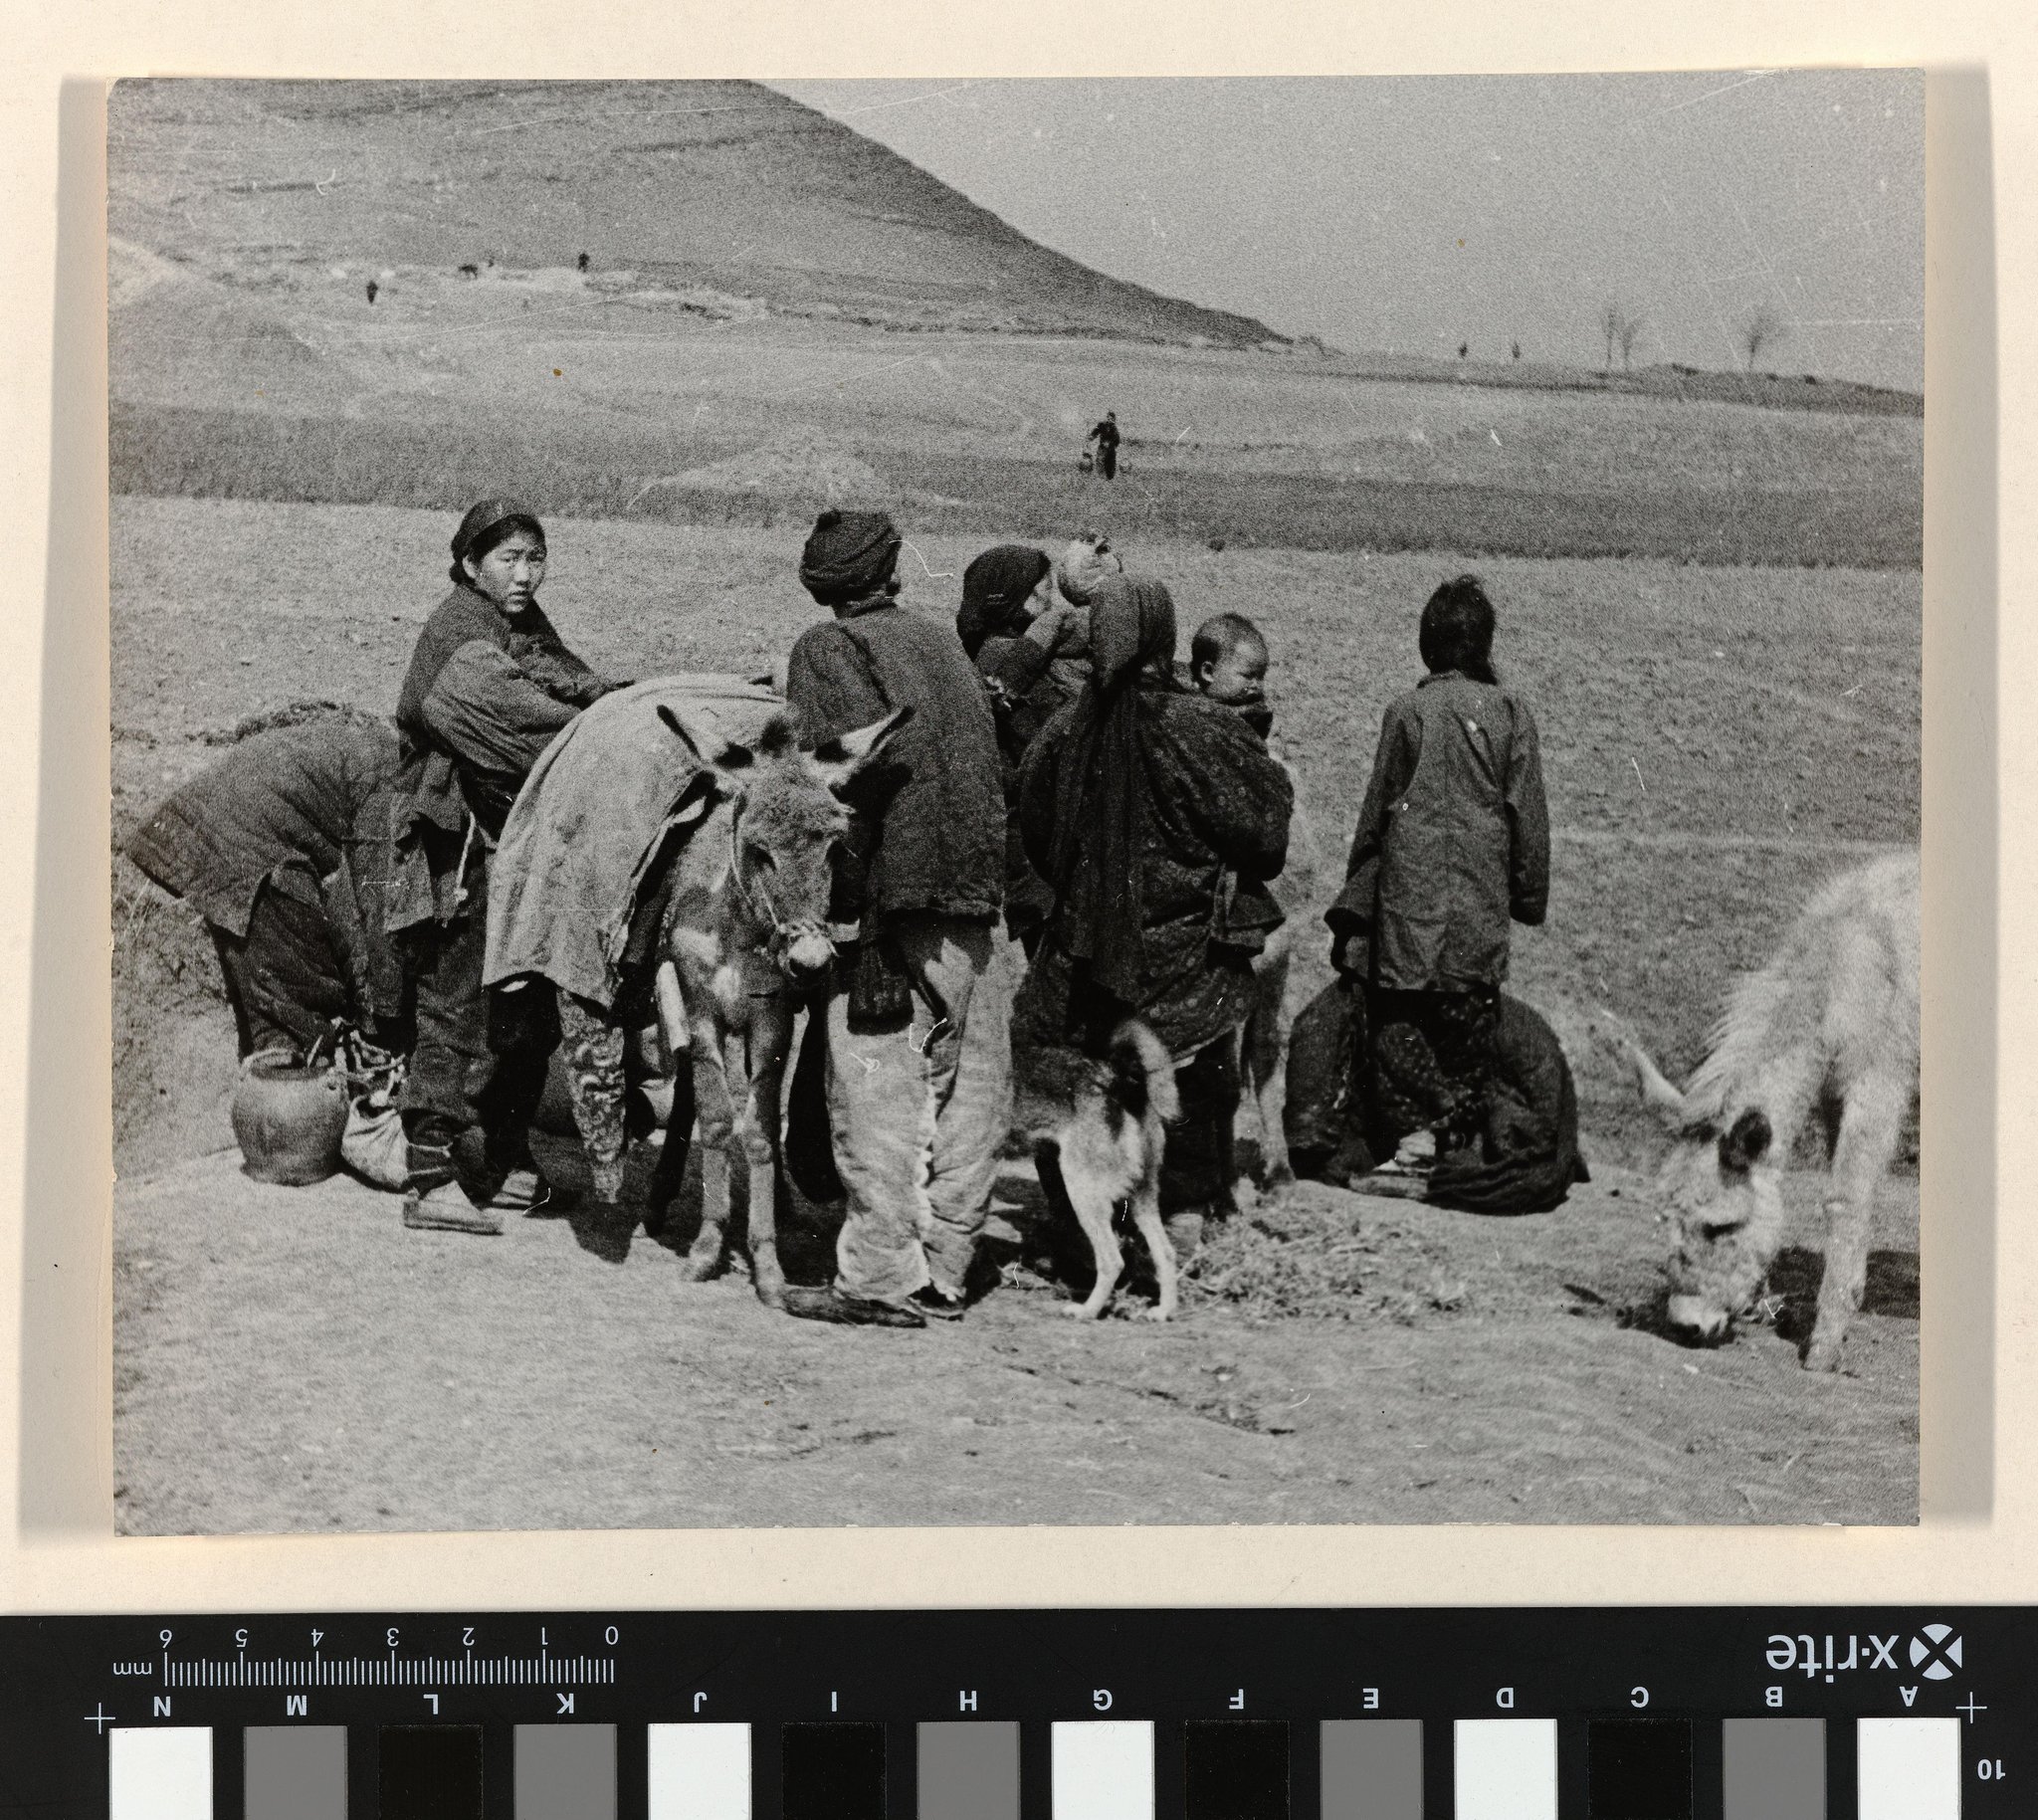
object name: news photograph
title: Groep mensen met dieren in het veld, China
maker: robert capa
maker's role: fotograaf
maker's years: 1913-1954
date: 1938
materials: paper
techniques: gelatin silver print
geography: new york city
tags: fugitives 'en route', ass, donkey, china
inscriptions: stamp: ‘PHOTO BY:/ PIX PUBLISHING INC./ 250 PARK AVENUE/ NEW YORK CITY/ TEL.ELDORADO 5-4021/ PLEASE CREDIT ROBERT CAPA - PIX/ THIS PICTURE IS SOLD TO YOU FOR YOUR/ PUBLICATION ONLY AND MUST NOT BE/ LOANED, SYNDICATED OR USED FOR AD-/ VERTISING PURPOSES WITHOUT WRITTEN/ PERMISSION FROM US.’, number: ‘13’